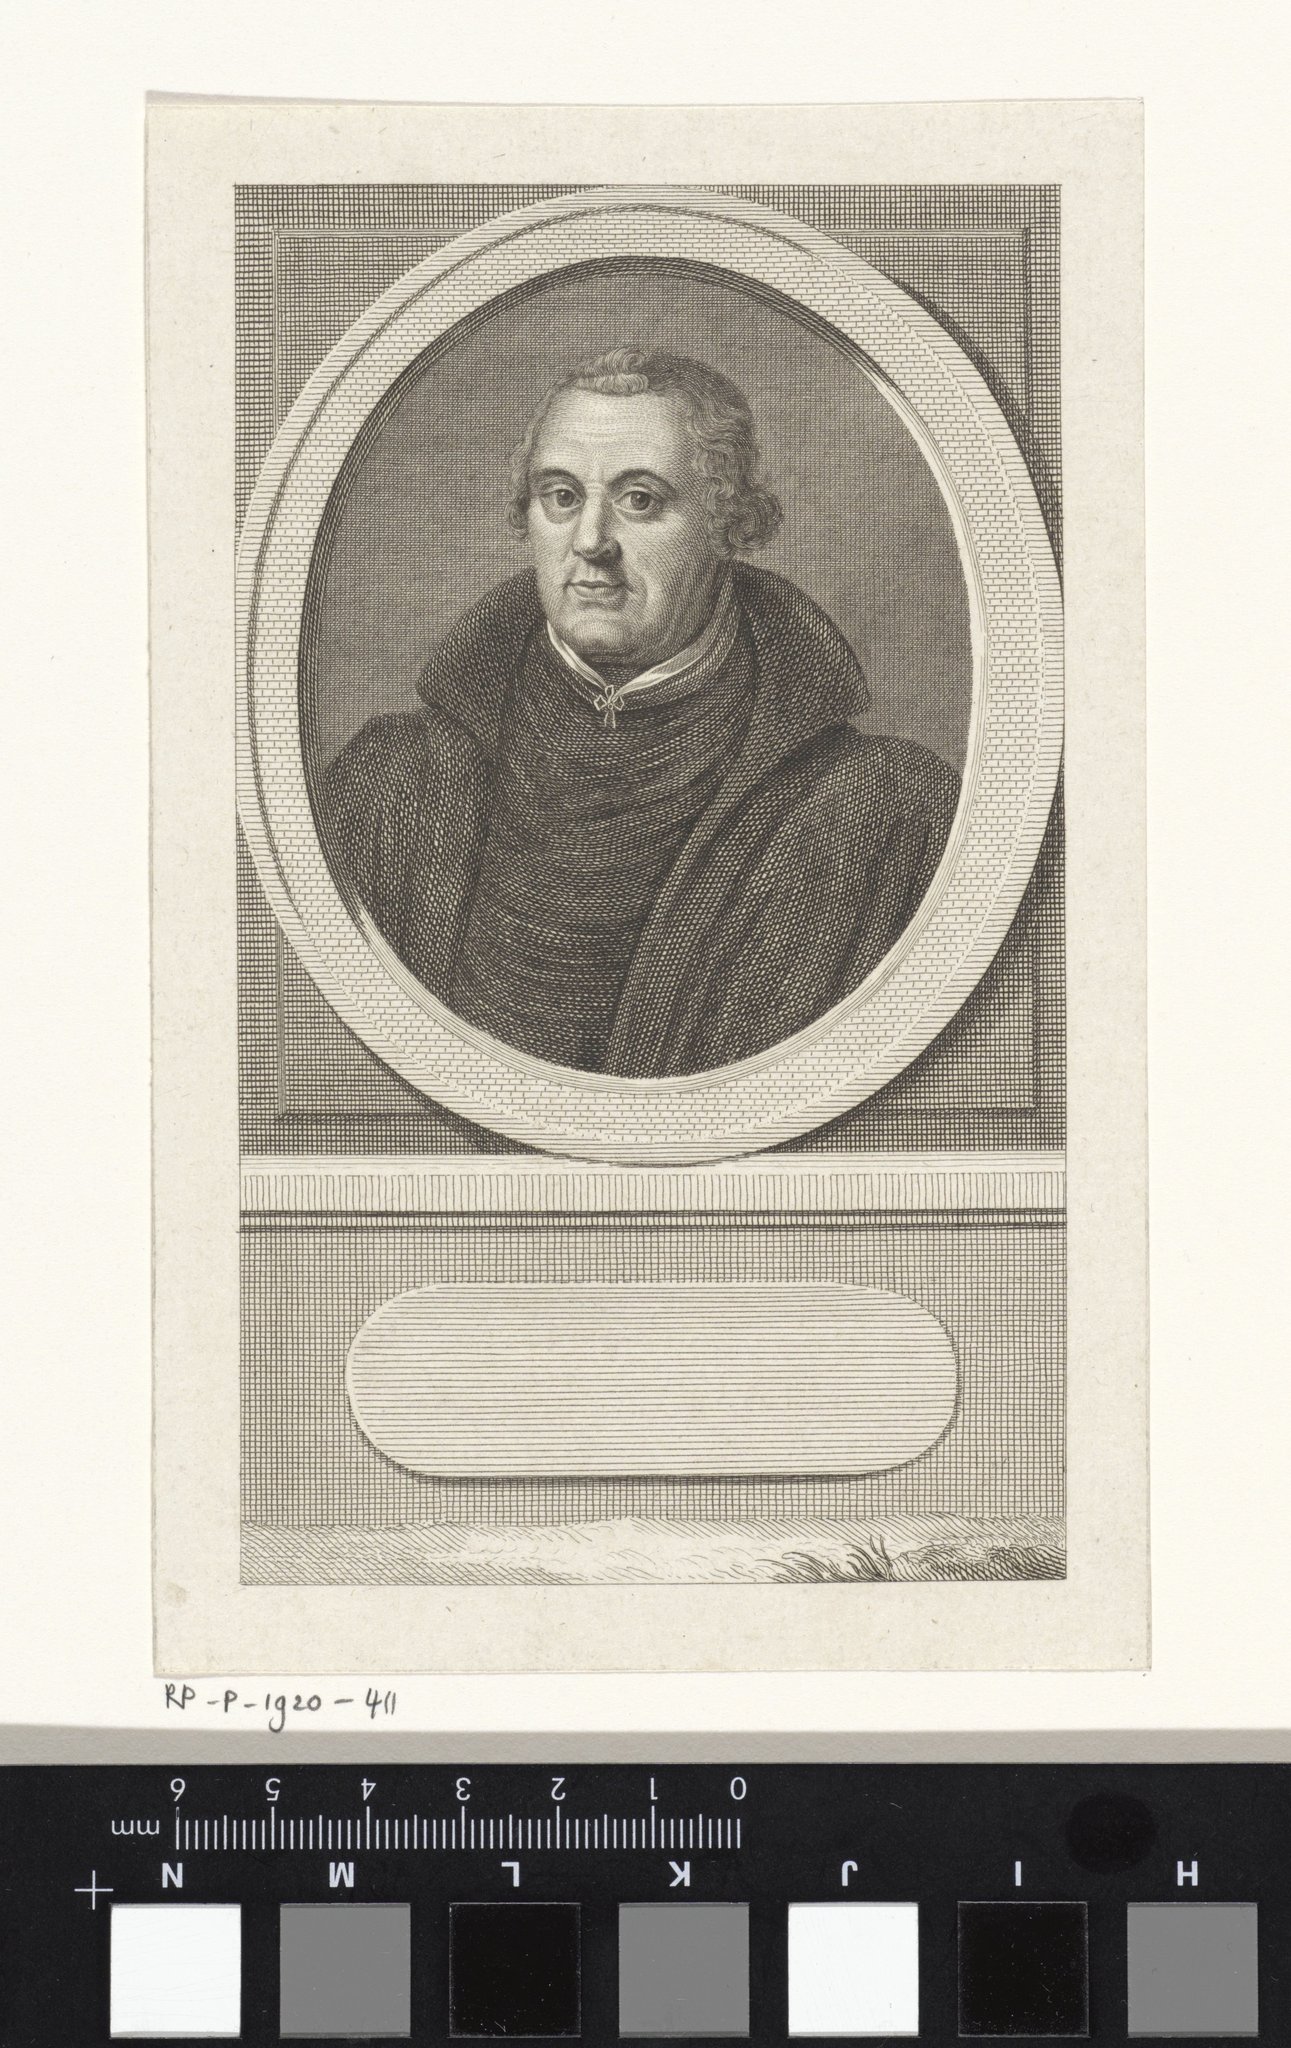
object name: print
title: Portret van Georg von Vincke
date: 1849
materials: paper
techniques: tone lithography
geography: mainz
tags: eyeglasses, spectacles, adult man, historical persons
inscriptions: collector's mark: Lugt 2228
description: Prent behoort waarschijnlijk tot de serie 'Album der deutschen National-Versammlung'. Deze serie bestaat uit circa 54 portretten die onder andere zijn vervaardigd door Philipp Winterwerb en Heinrich Hasselhorst naar foto's van Seib. Deze serie is in 1849 uitgegeven door Carl Christian Jügel.